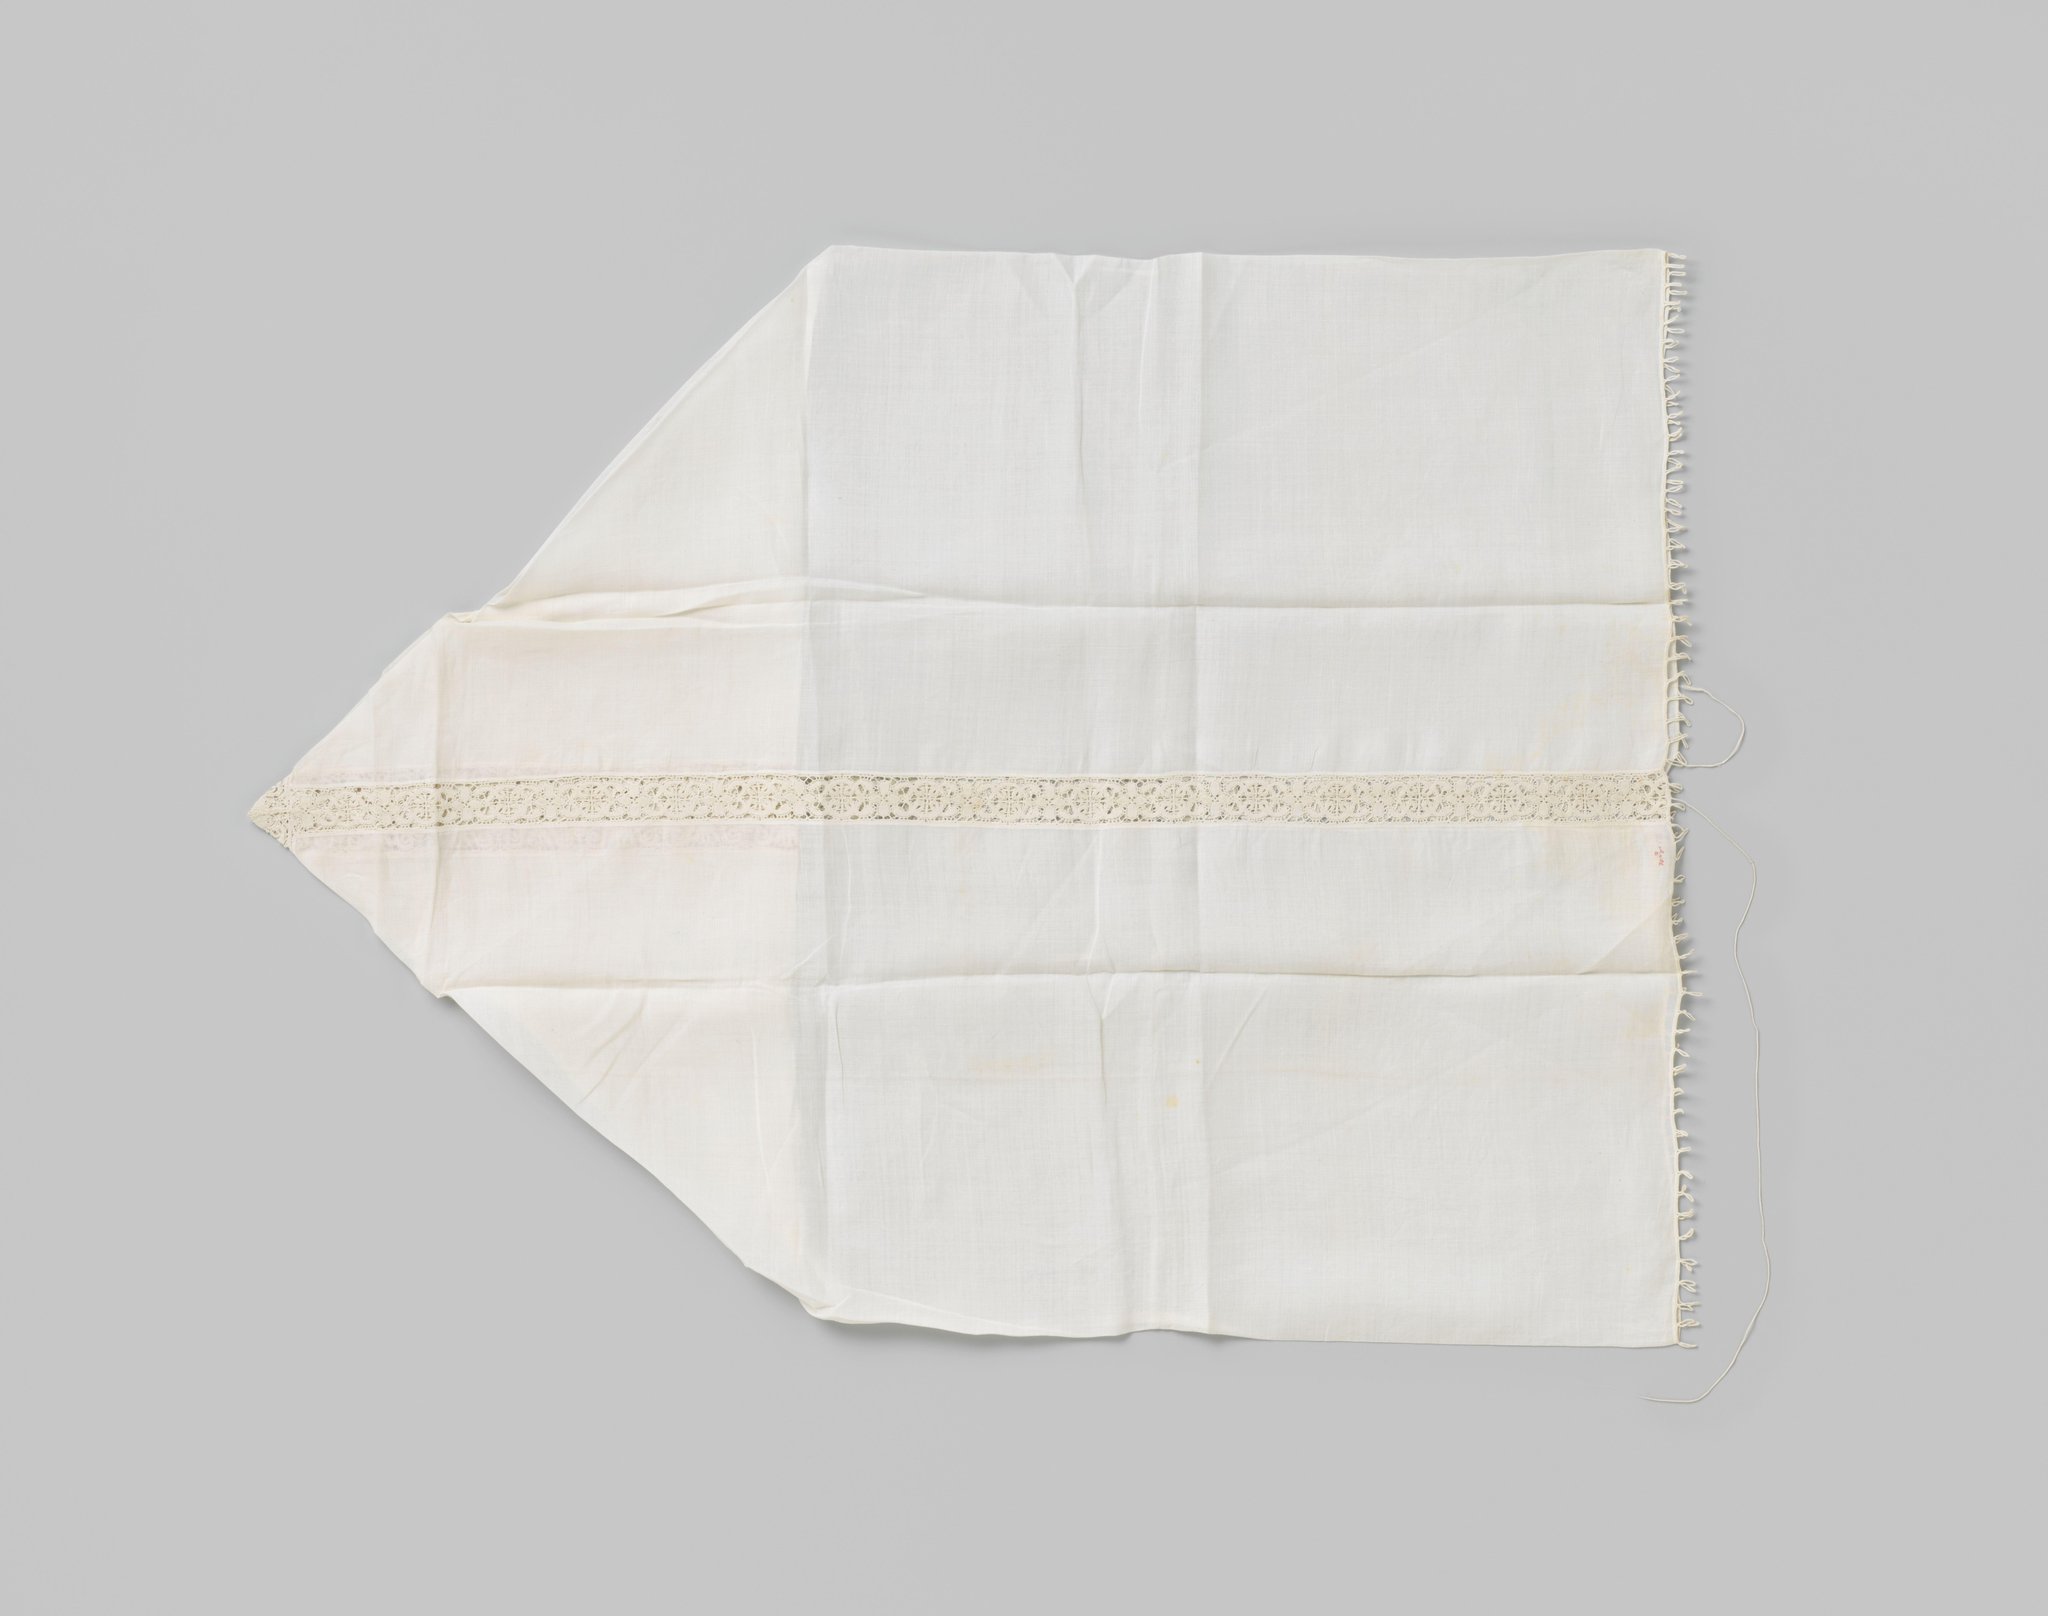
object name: sloop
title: Linnen sloop aan drie zijden versierd met Vlaams kloskant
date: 1700-1800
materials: linen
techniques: lace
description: Linnen sloop aan drie zijden voorzien van een tussenzetsel van Vlaams kloskant, waarvan die aan de korte zijde de breedste is. Aan de bovenkant afgemaakt met een bandje, dat in lussen gedraaid is.